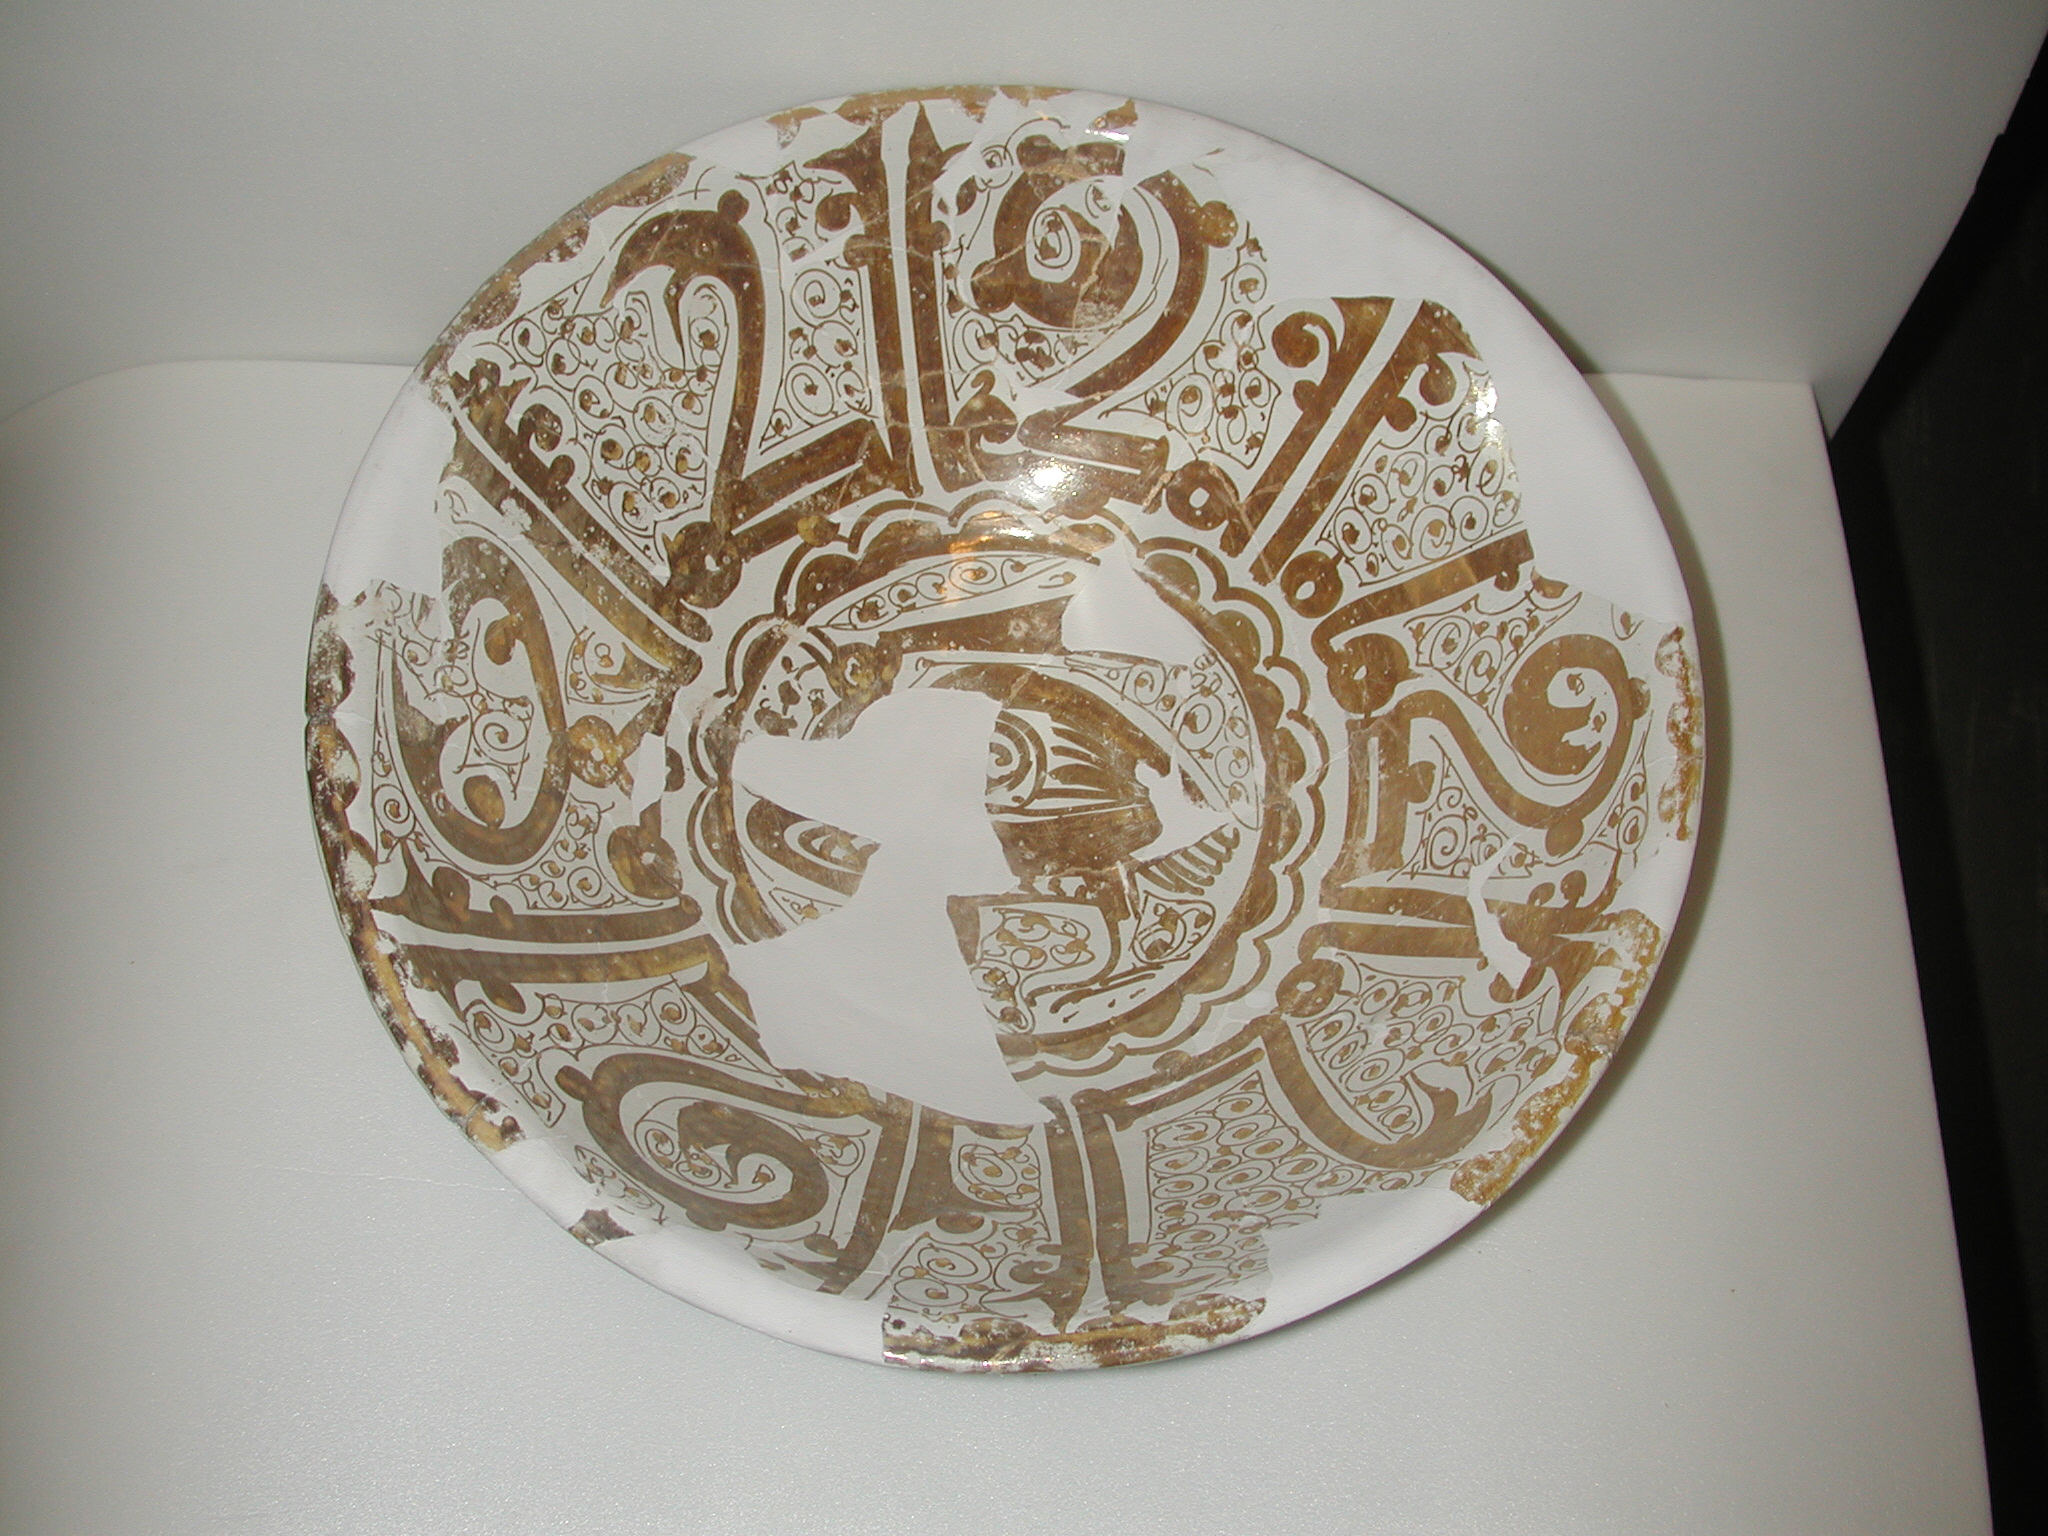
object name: bowl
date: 1067-1200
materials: earthenware, glaze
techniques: luster painting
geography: egypt